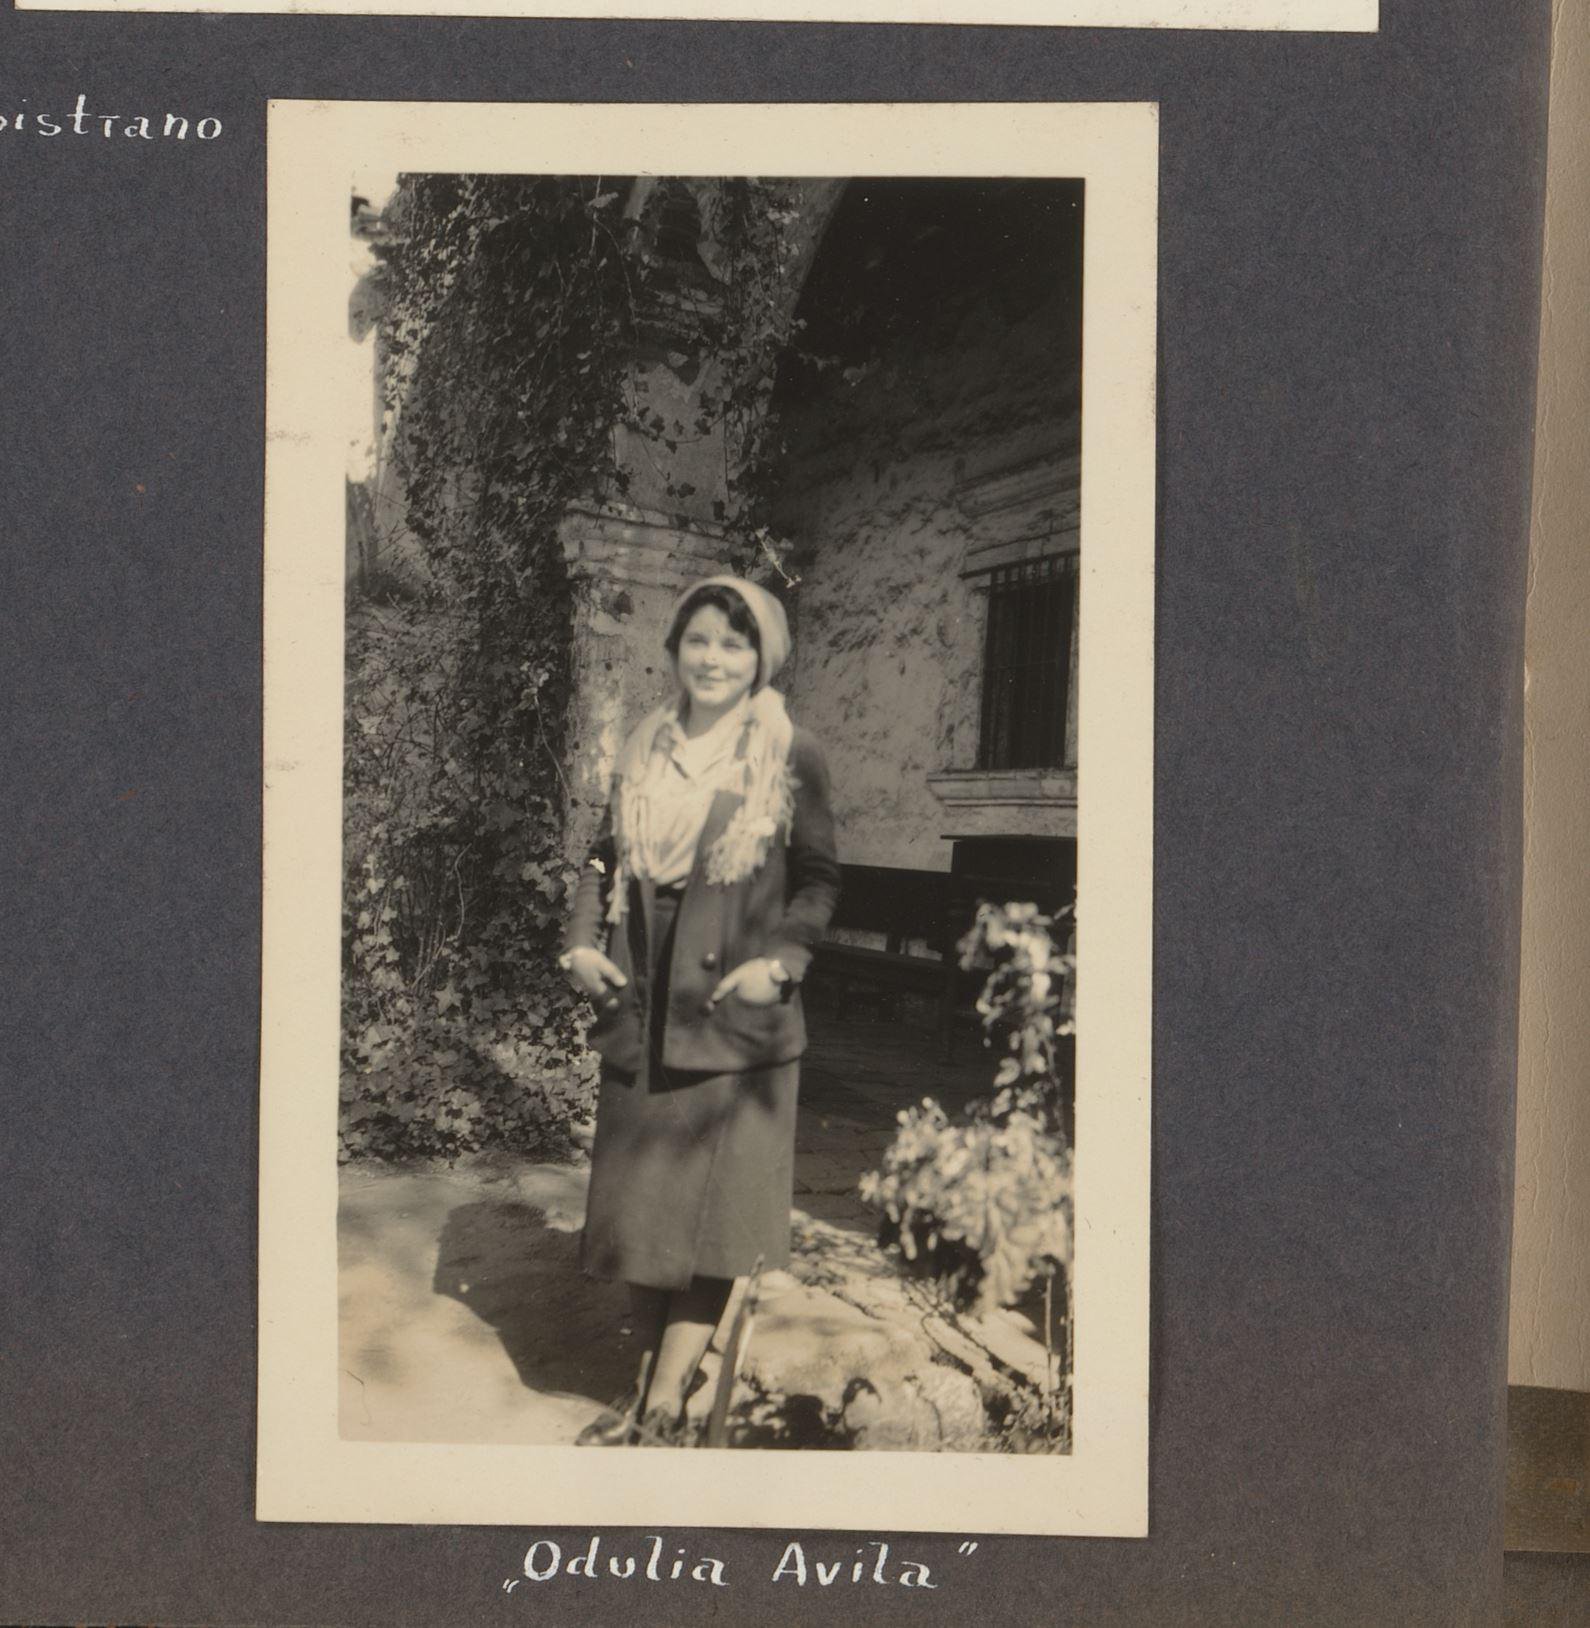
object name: album leaf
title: Portret van Odulia Avila, vermoedelijk bij Mission San Juan Capistrano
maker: Anonymous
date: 1928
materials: photographic support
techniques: gelatin silver print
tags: adult woman, historical persons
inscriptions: annotation: ‘Odulia Avila’